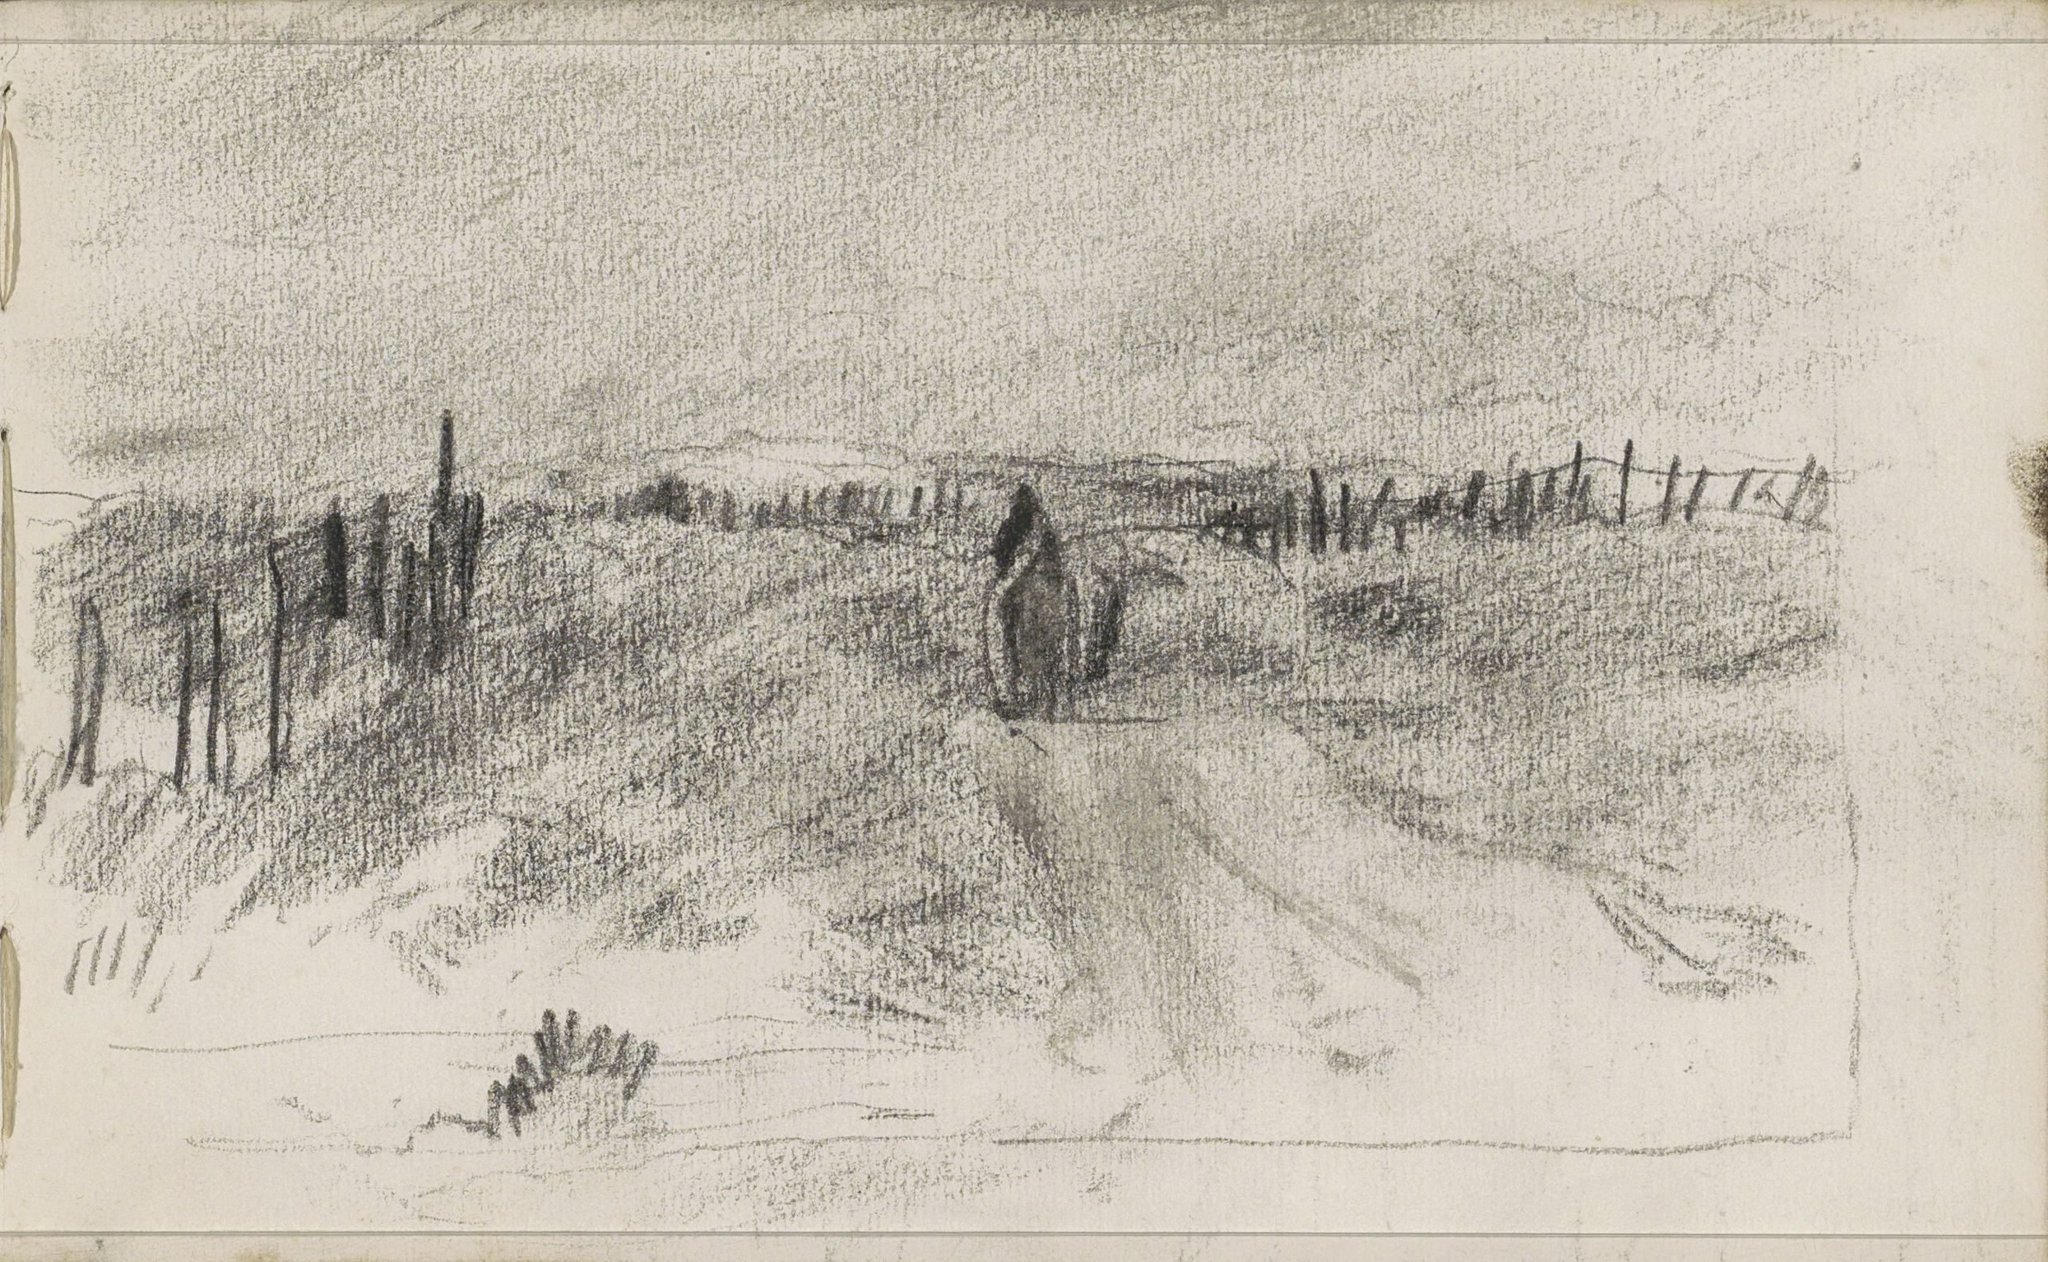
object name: sketchbook leaf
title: Figuur op een pad in een landschap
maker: anton mauve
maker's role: draughtsman, painter, print maker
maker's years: 1838-1888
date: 1848-1888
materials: chalk, paper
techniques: brush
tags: road, path, landscapes (+ landscape with figures, staffage)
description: Blad 3 recto uit een schetsboek met 41 bladen.